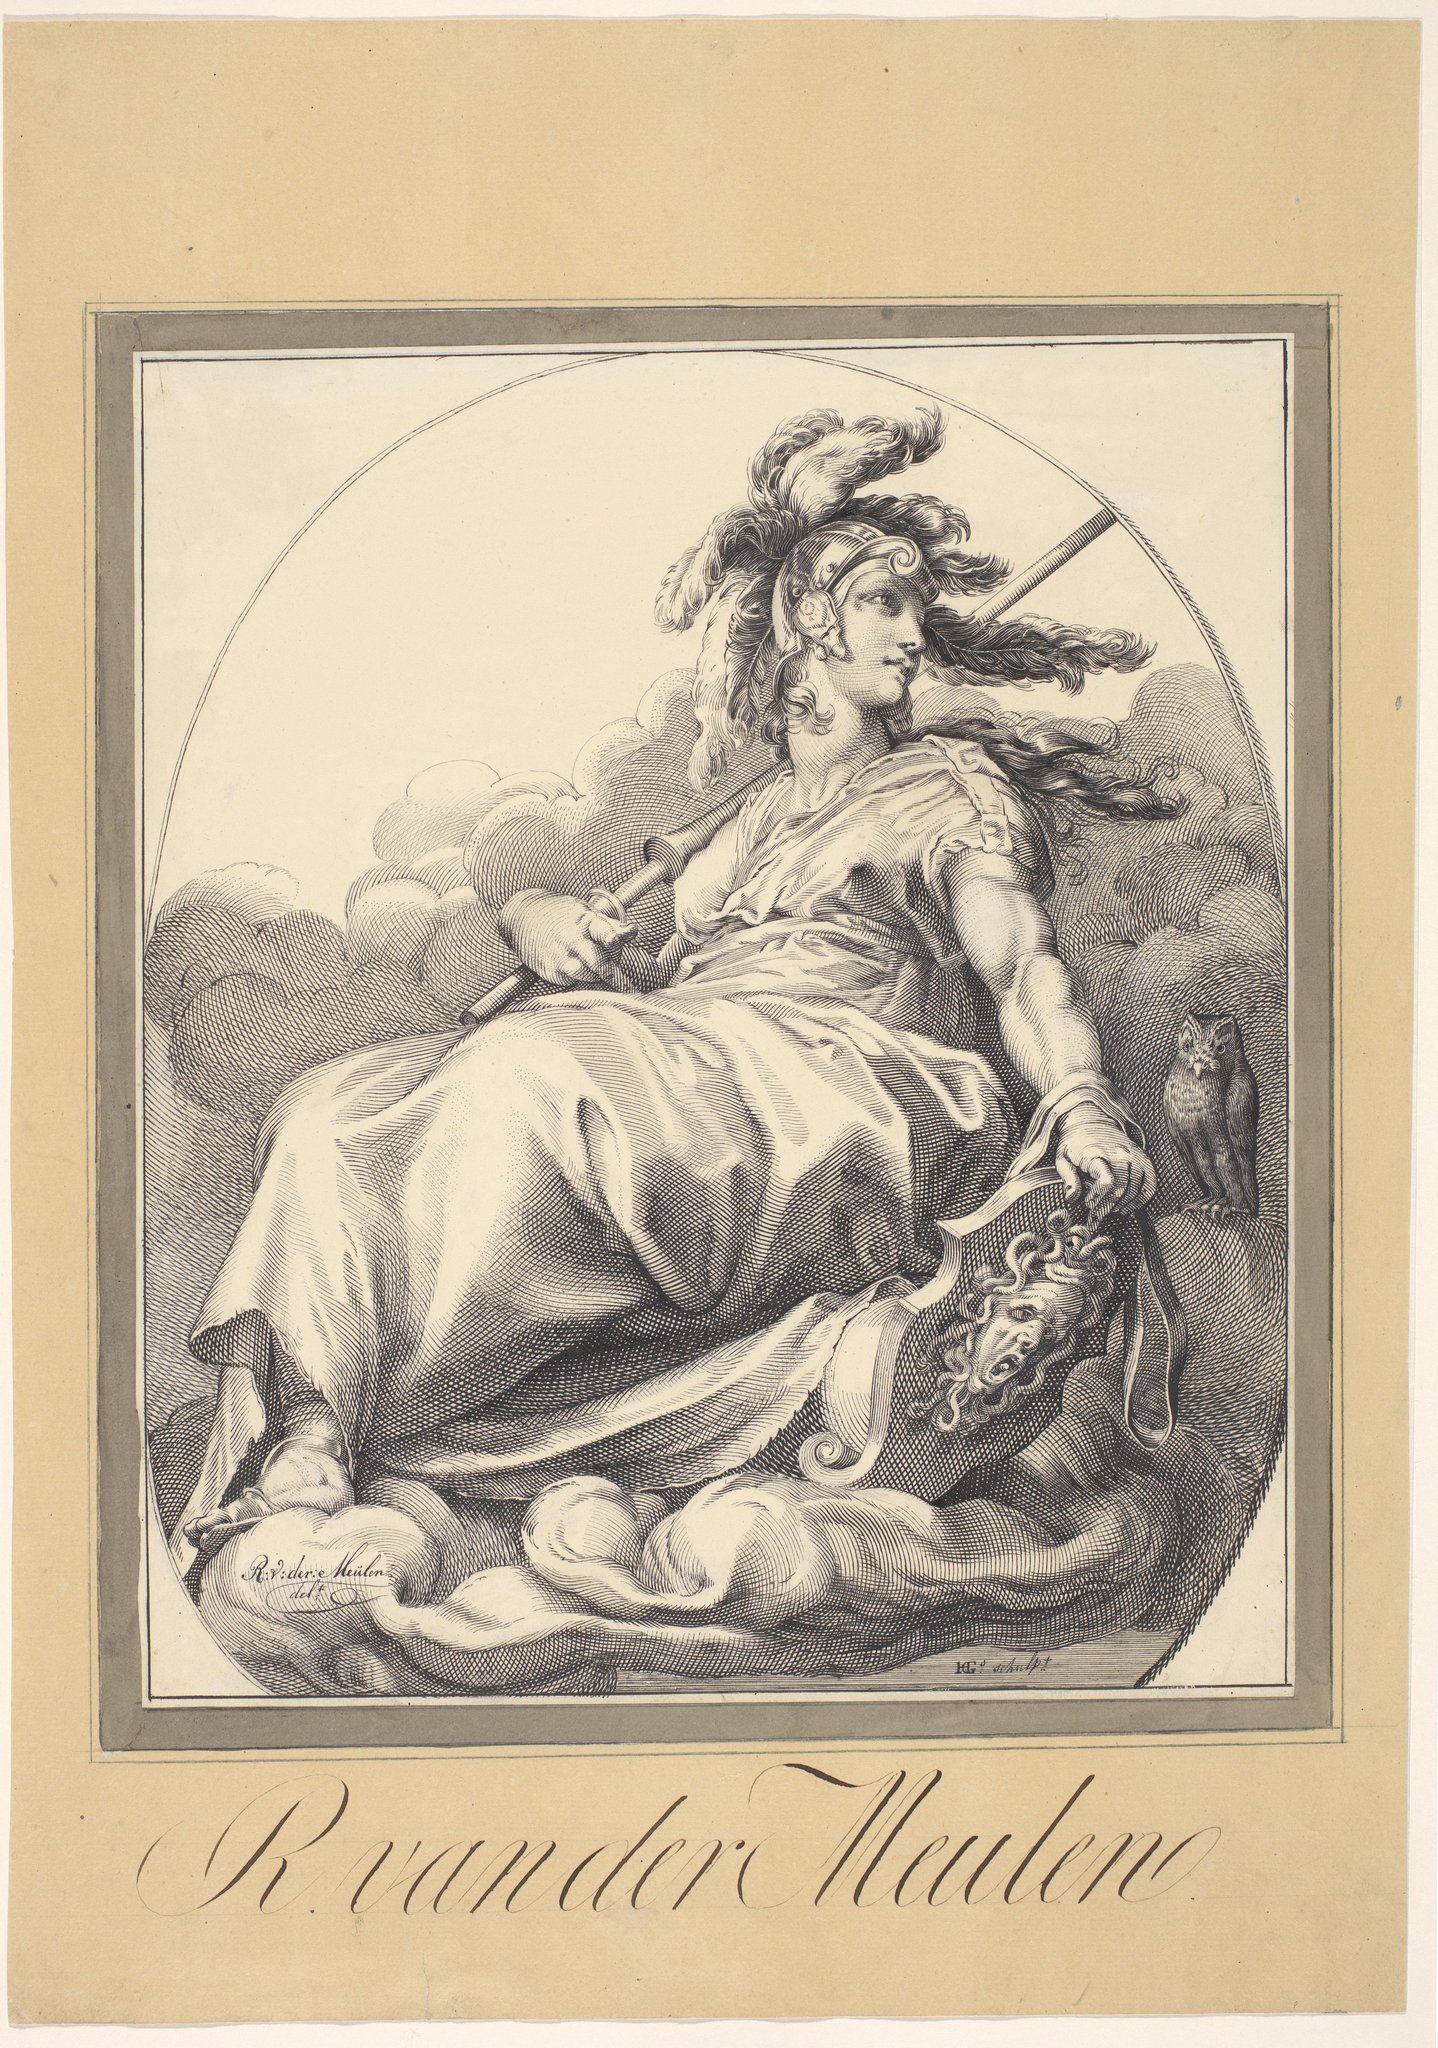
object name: drawing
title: Minerva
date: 1816-1833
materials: ink, paper, pencil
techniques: pen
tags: (story of) minerva (pallas, athena)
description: Minerva zittend in haar wapenrusting op een wolk met rechts een uil.